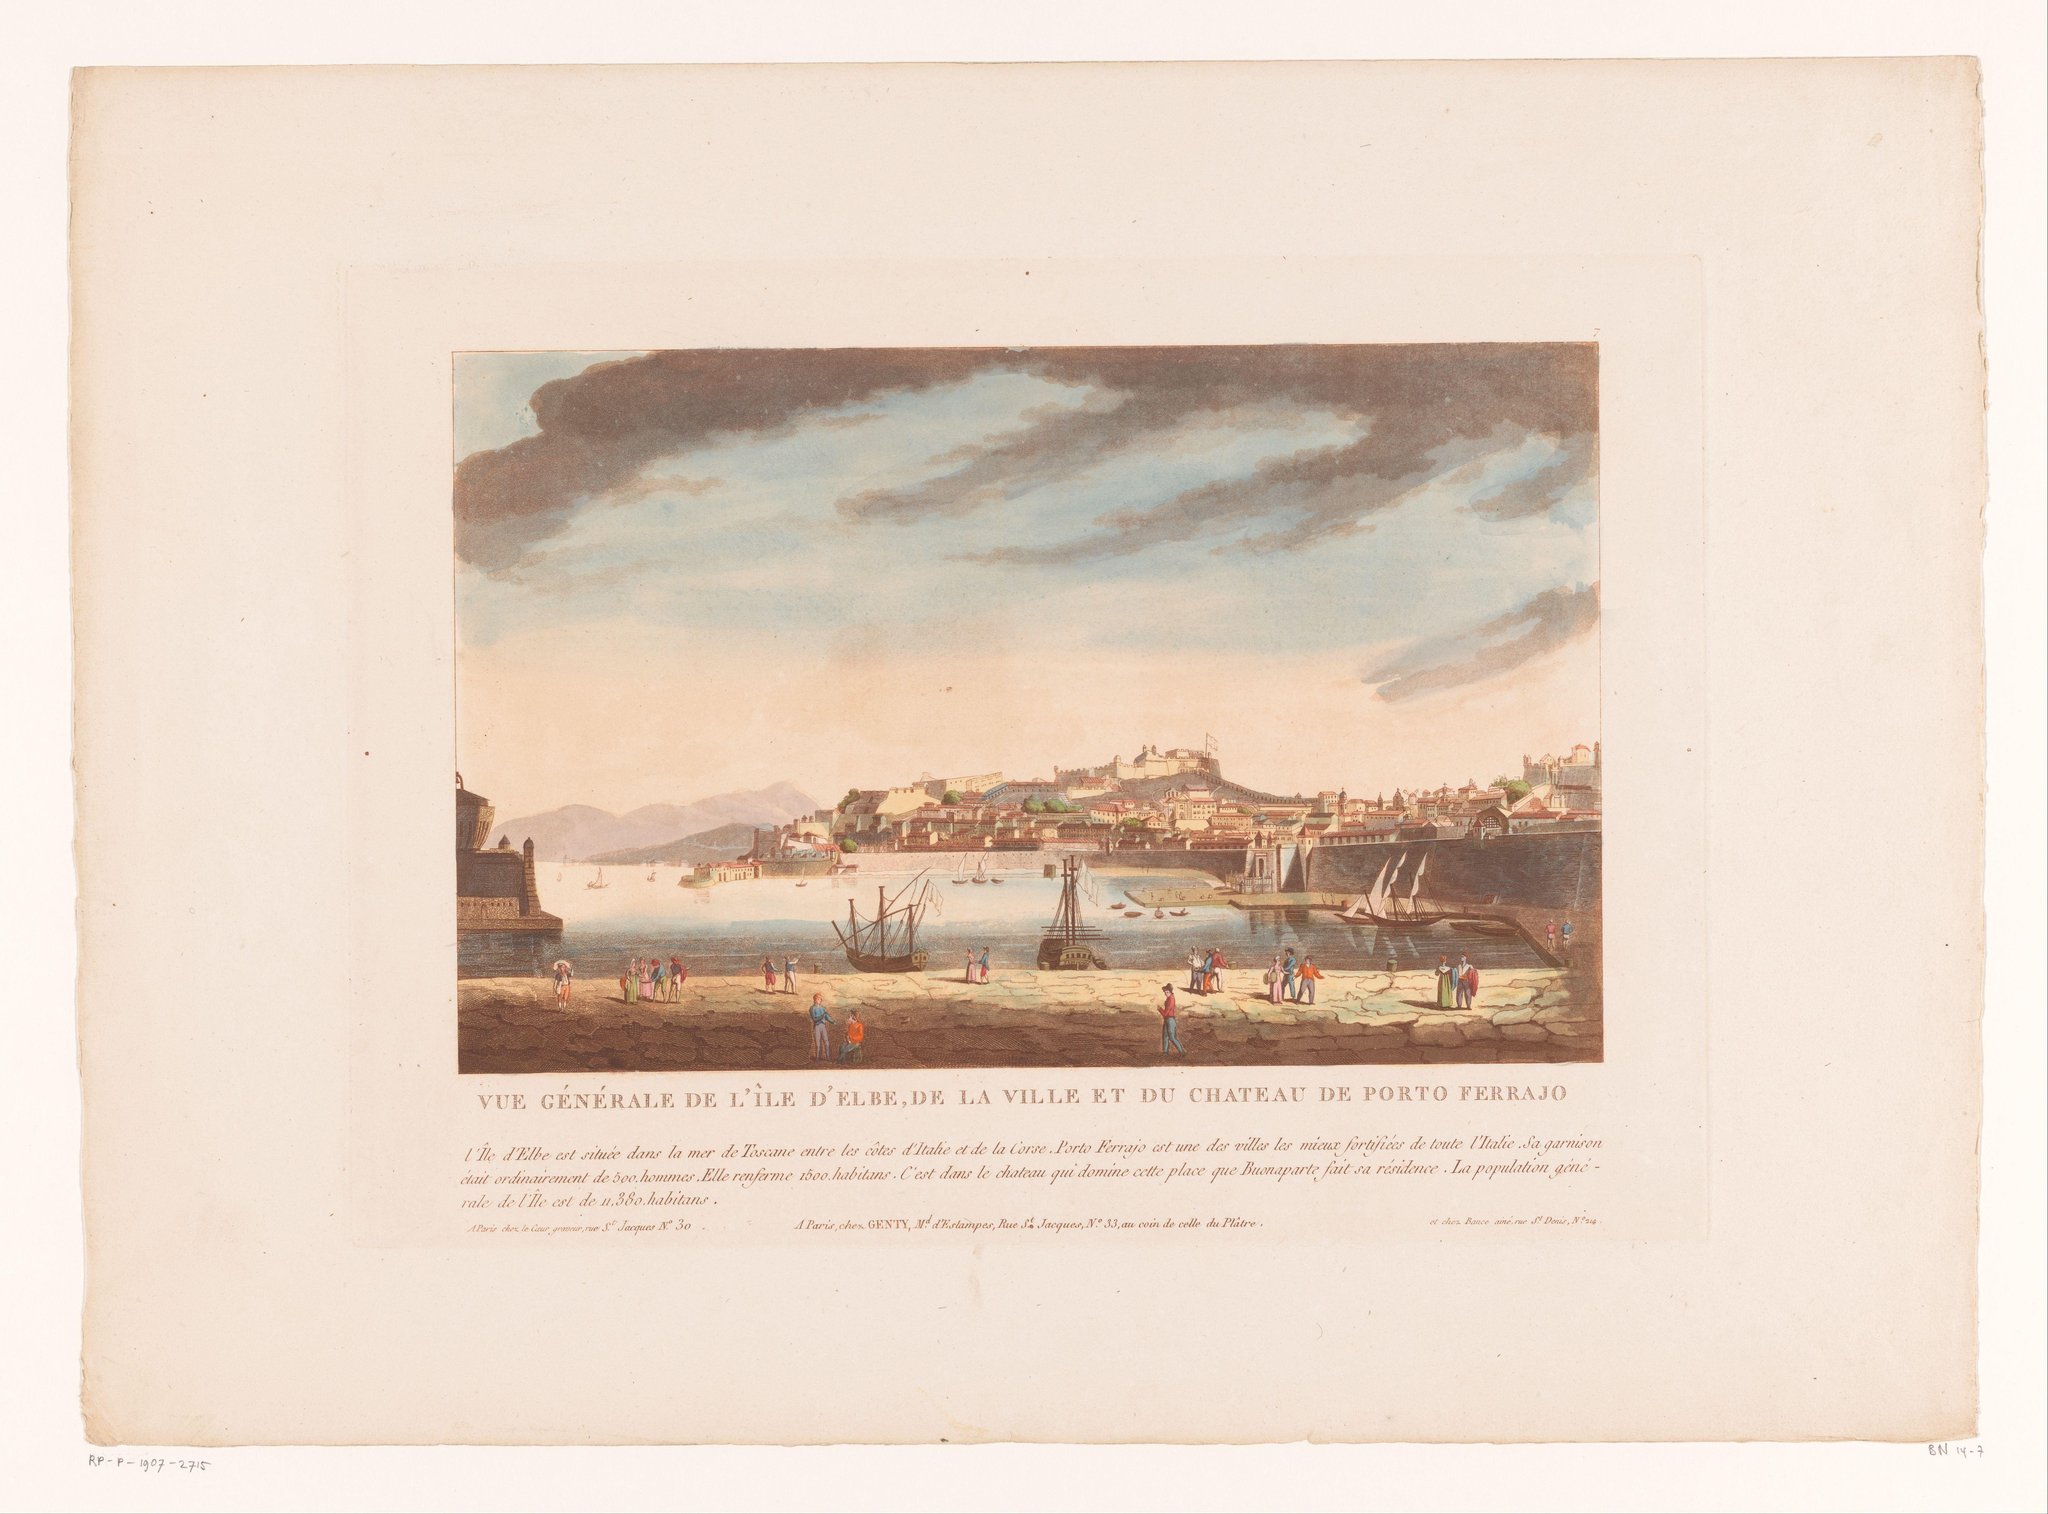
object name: print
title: Vue Générale de L'île d'Elbe, de la Ville et du Cateau de Porto Ferrajo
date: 1812-1814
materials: paper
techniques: aquatint, etching, hand coloring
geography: paris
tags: harbour, island, city-view in general; 'veduta'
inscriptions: collector's mark: Lugt 2228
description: Maakt mogelijk deel uit van een serie met stadsgezichten in Italië, Spanje en Egypte.